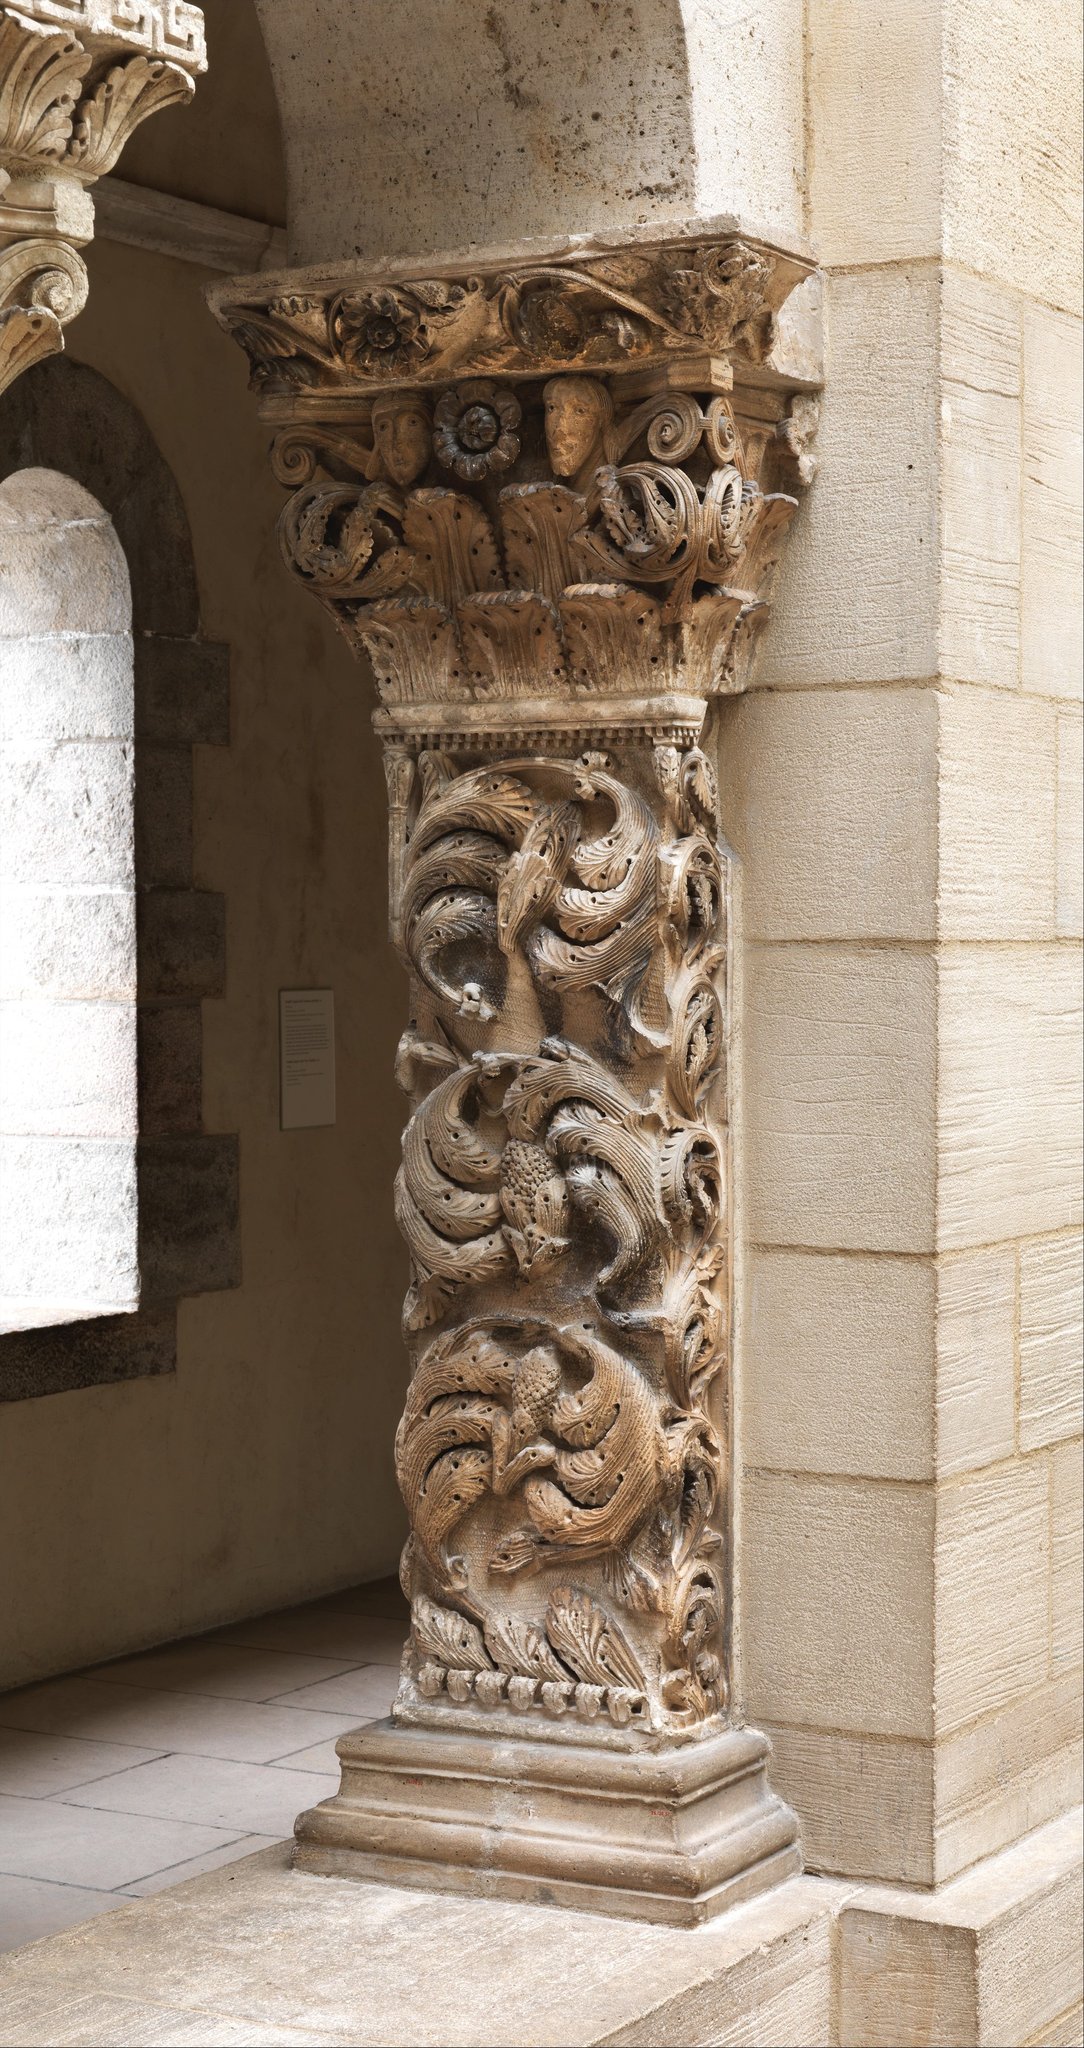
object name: pilaster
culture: french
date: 1167-1200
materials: stone